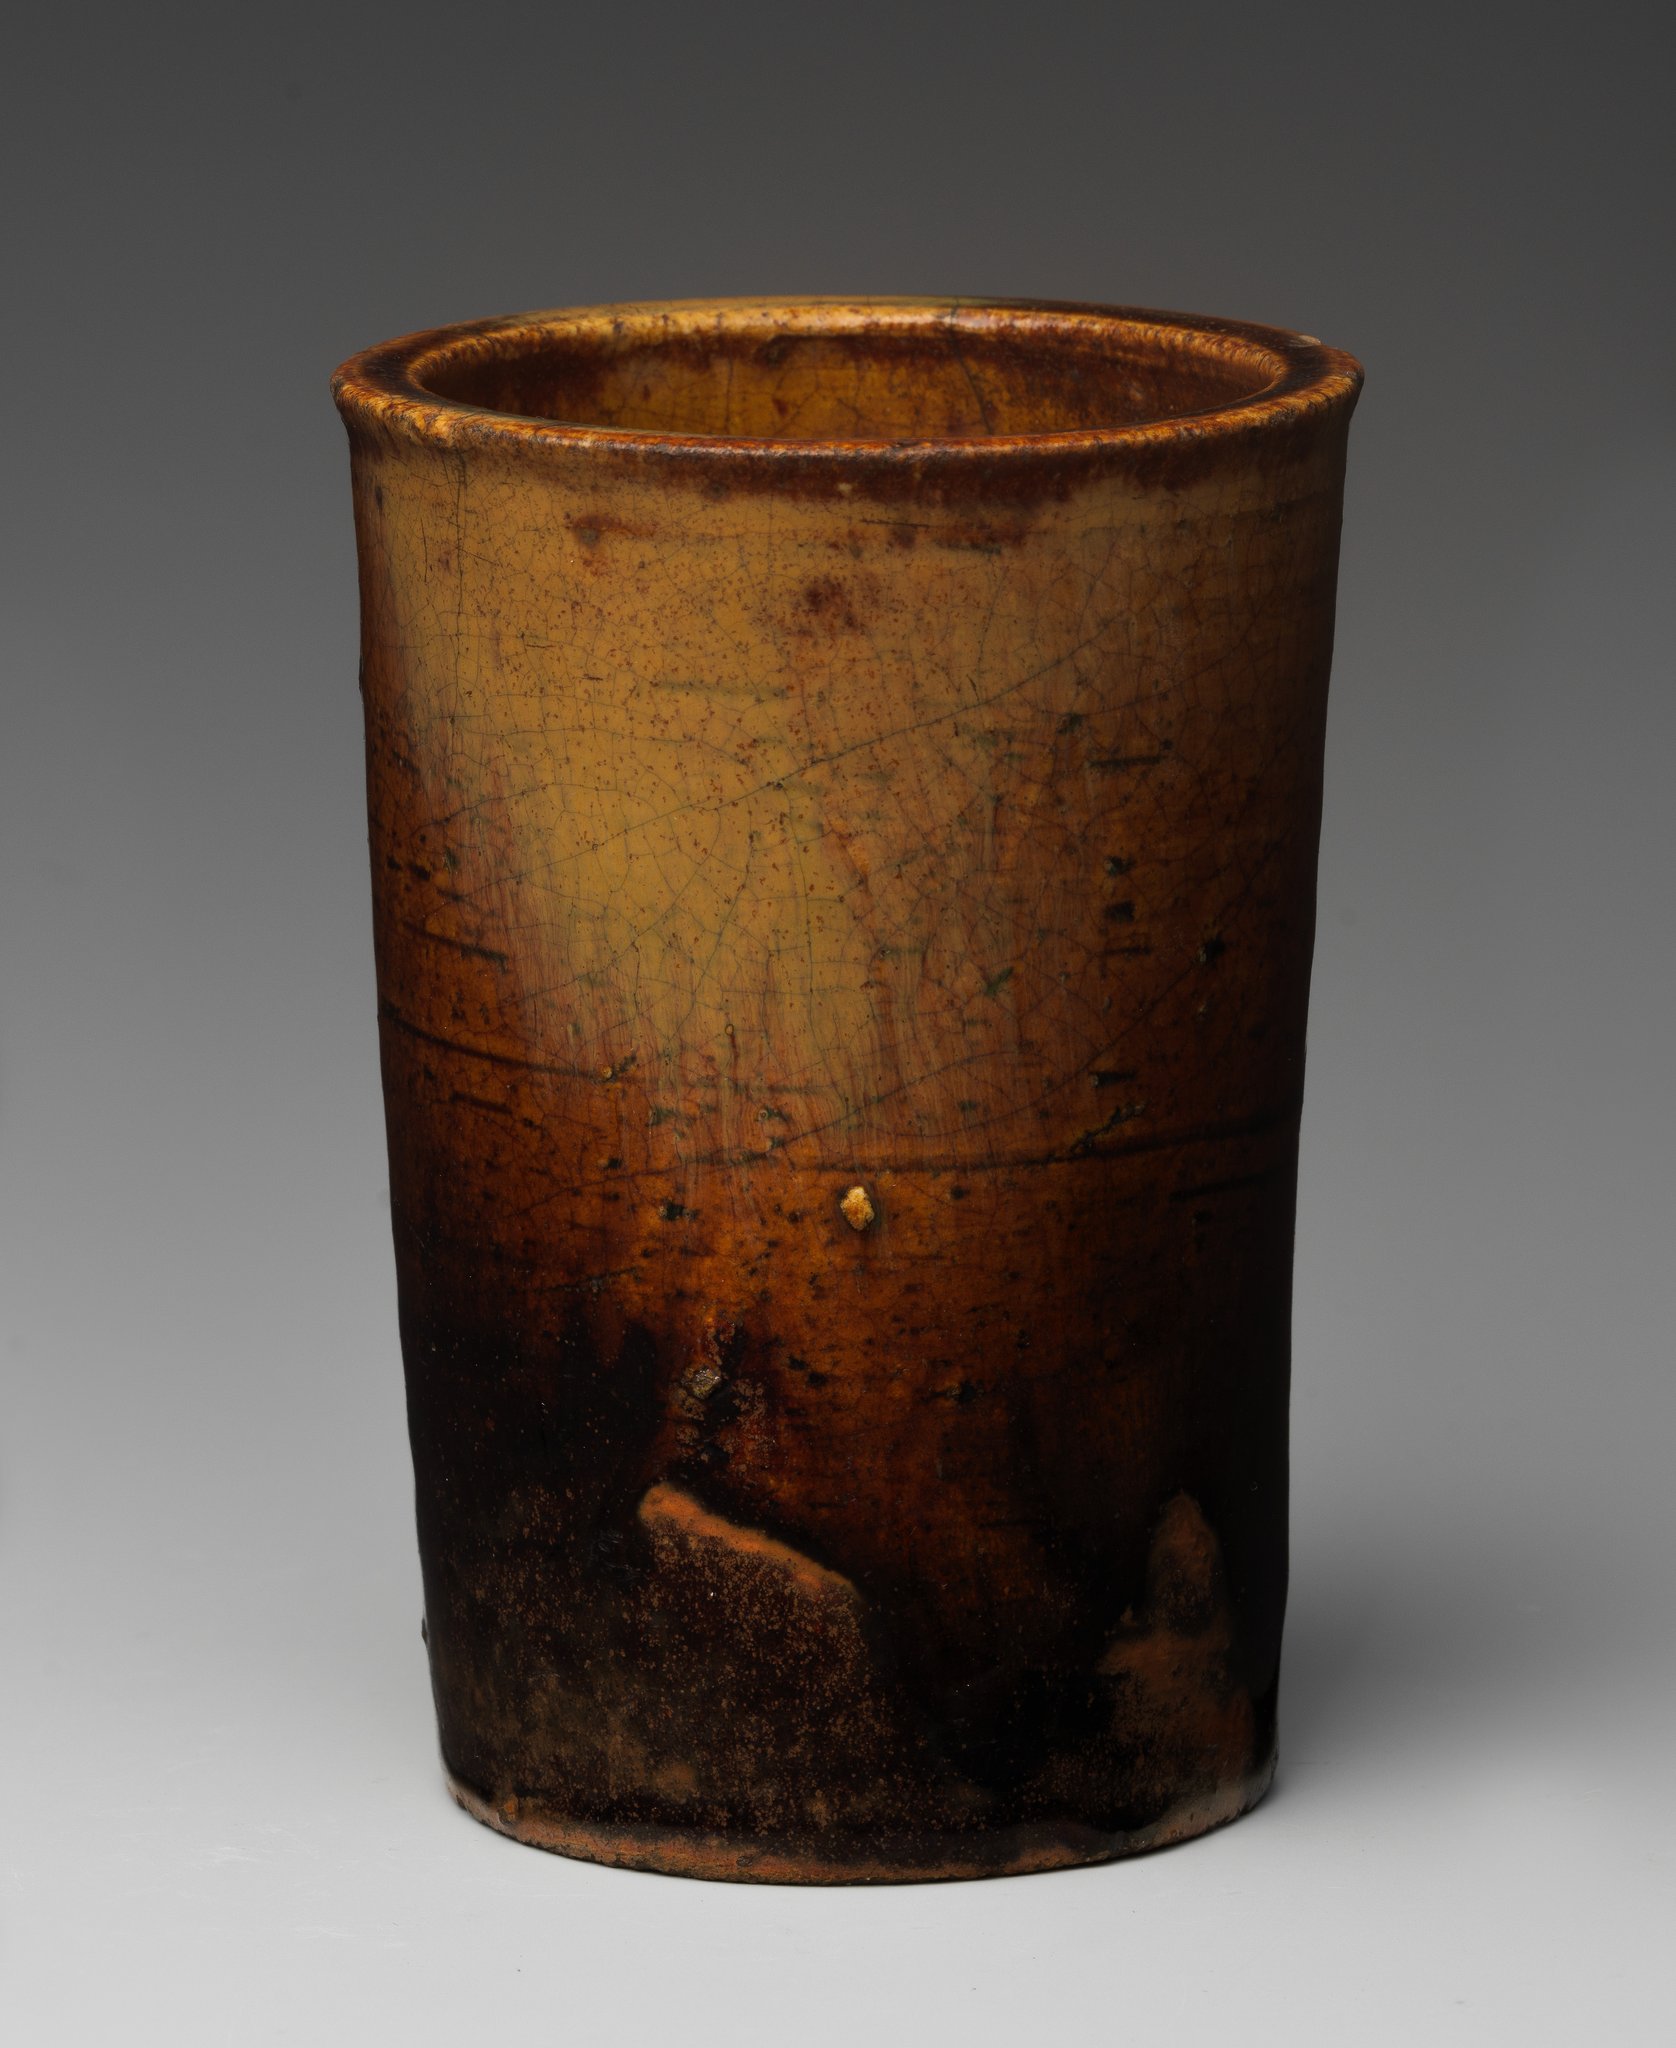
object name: hanging vase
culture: japanese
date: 1701-1800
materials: glaze, pottery